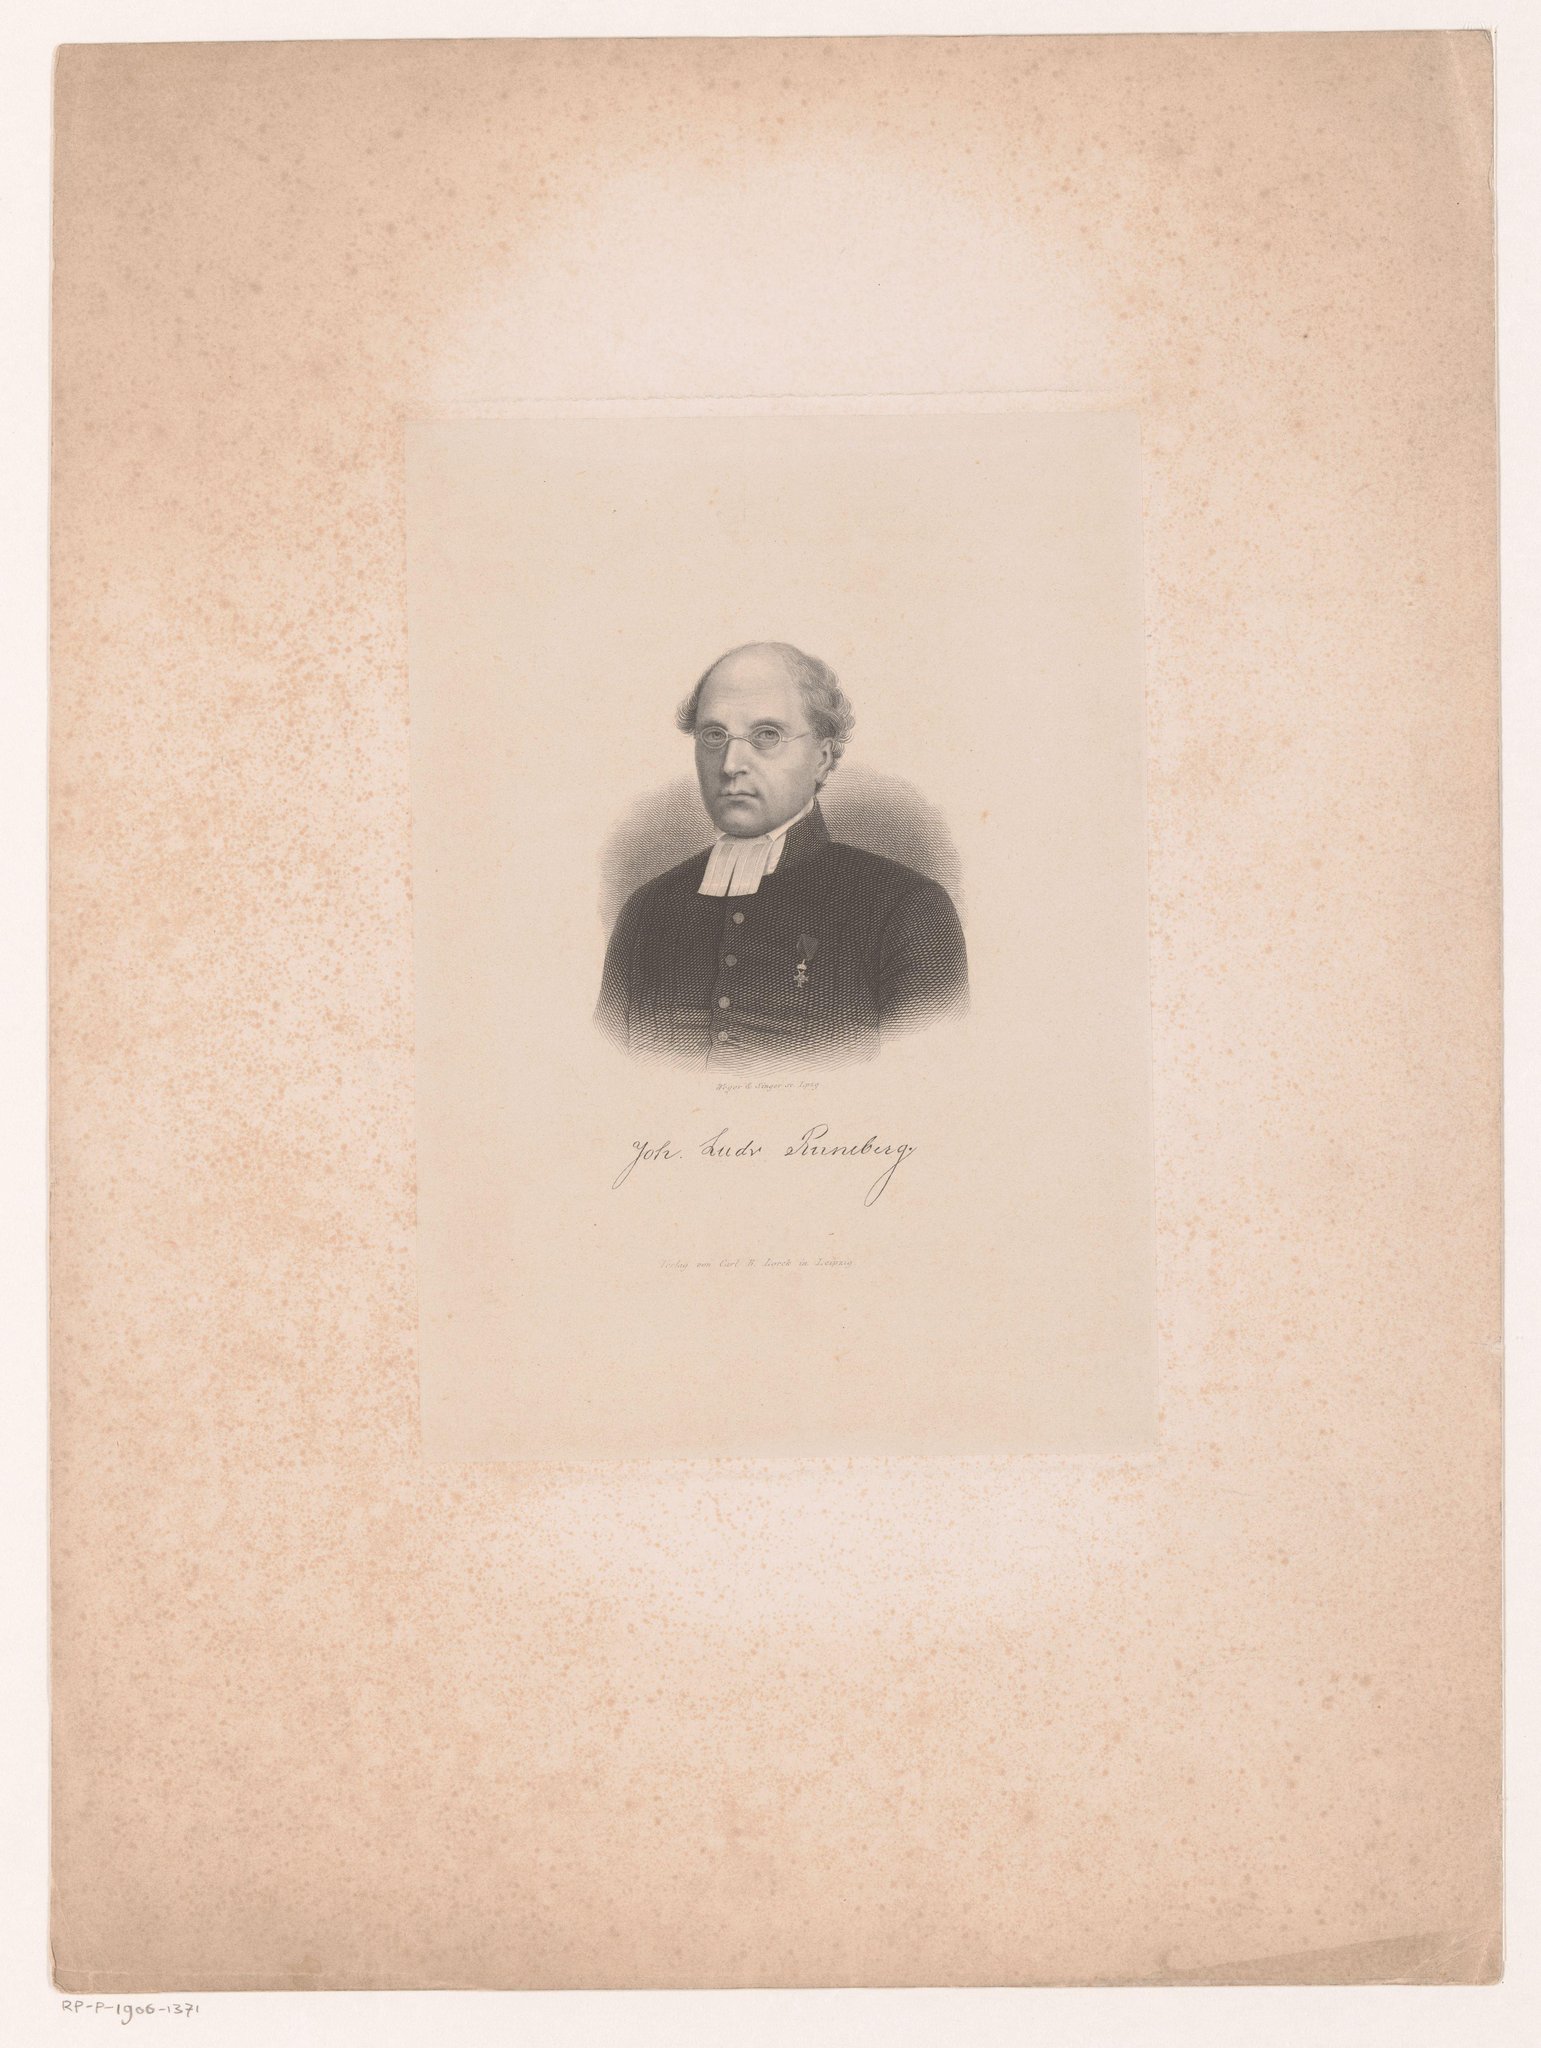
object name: print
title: Portret van Johan Ludvig Runeberg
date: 1849-1892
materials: paper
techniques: engraving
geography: leipzig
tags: historical persons, writer, poet, author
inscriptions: collector's mark: Lugt 2228